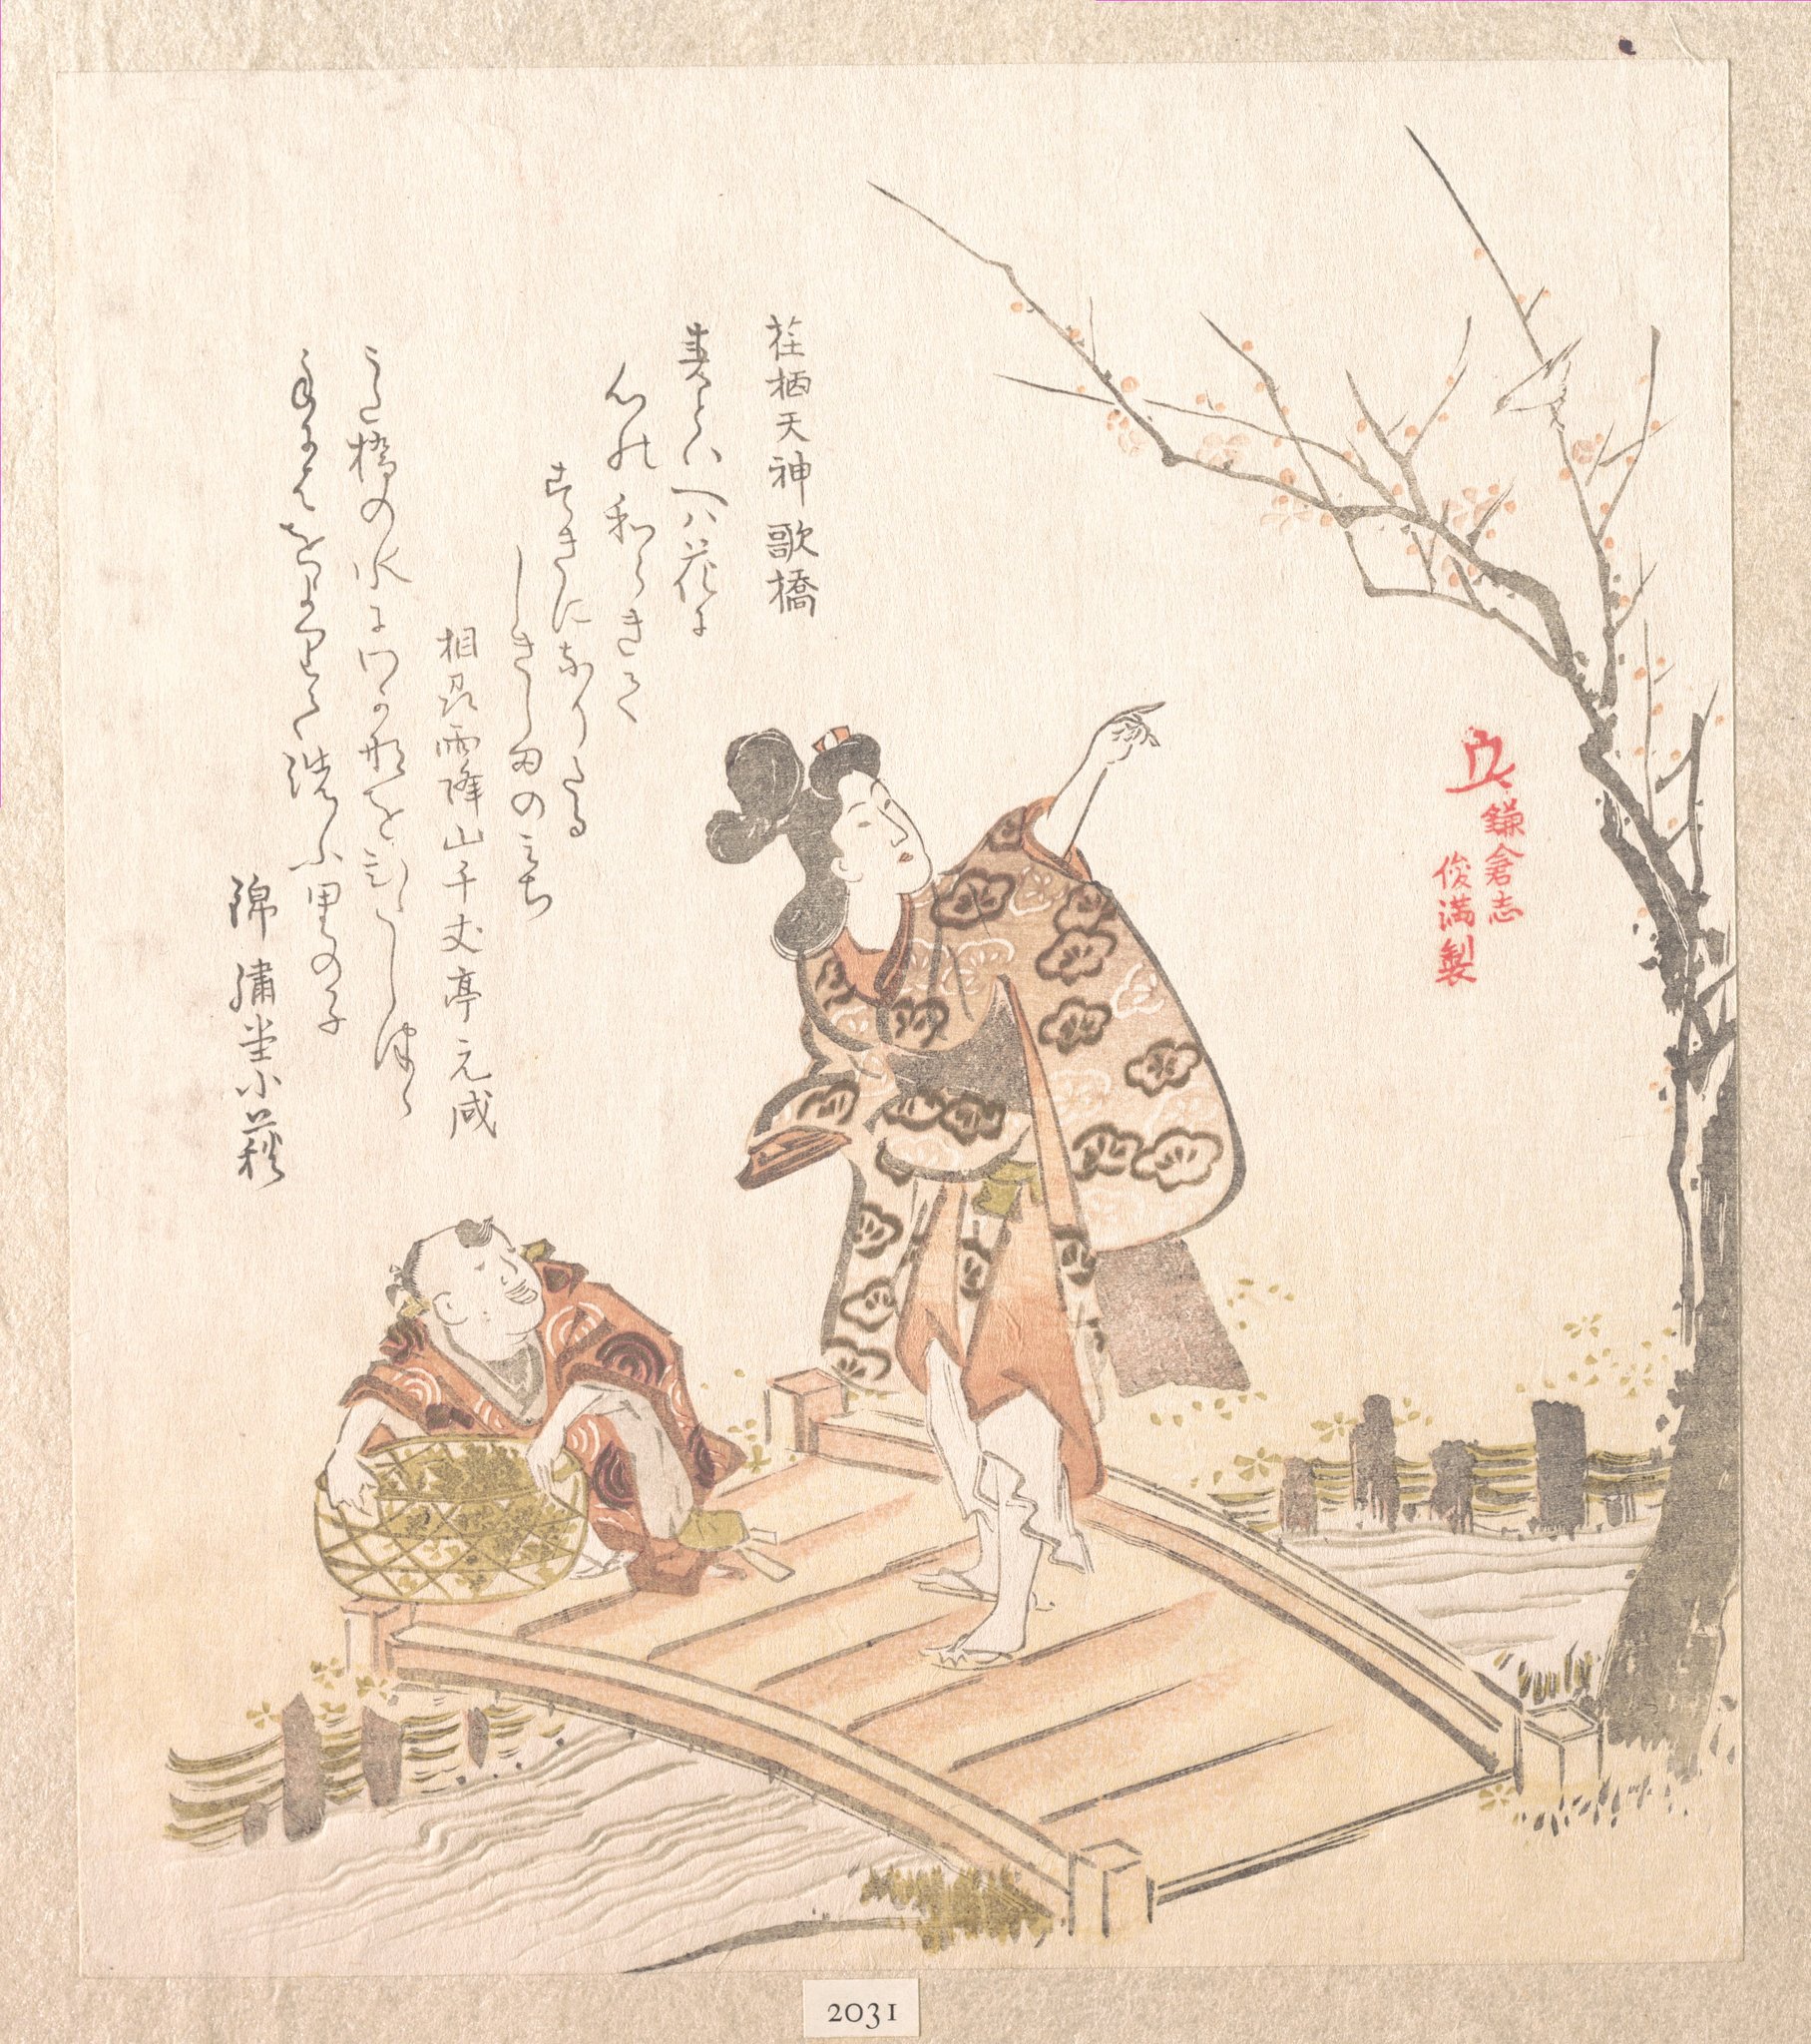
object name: print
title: History of Kamakura: Poem-bridge of Egara Tenjin Shrine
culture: japanese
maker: kubo shunman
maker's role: artist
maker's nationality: japanese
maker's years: 1757-1820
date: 1801-1900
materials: ink, paper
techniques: surimono, woodblock print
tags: bridges,men,women,trees